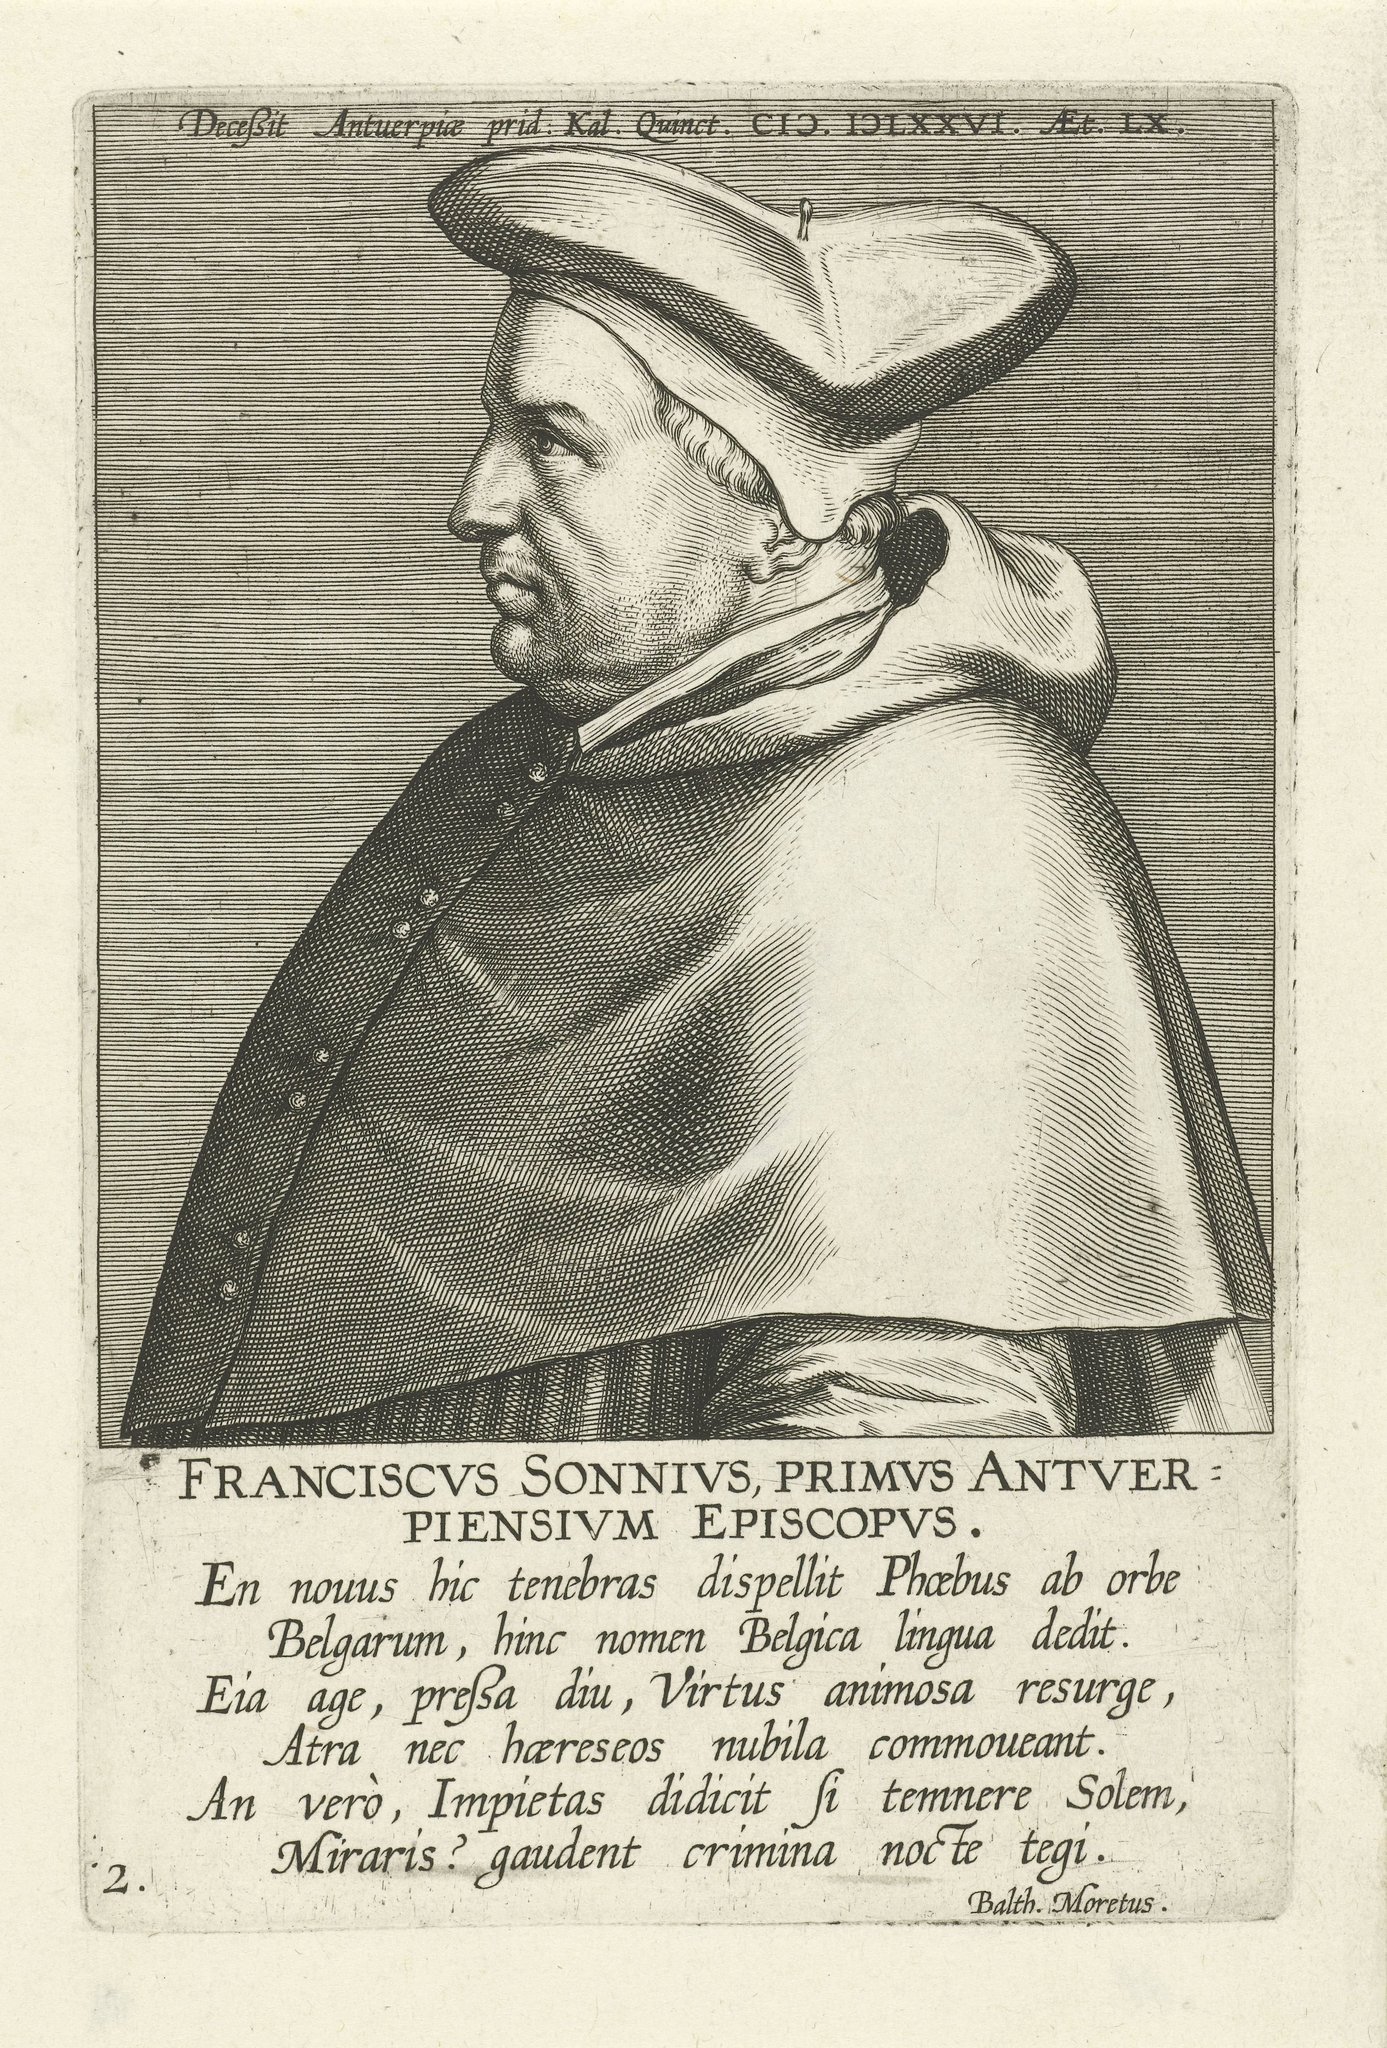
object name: print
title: Franciscvs Sonnivs, Prmvs Antverpiensivm Episcopvs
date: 1604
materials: paper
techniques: engraving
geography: antwerp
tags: antwerp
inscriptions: collector's mark: Lugt 2228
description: Portret van Fransiscus Sonnius, eerste bisschop van Antwerpen. In proefiel naar links. De prent heeft een Latijns boven- en onderschrift en maakt deel uit van een serie van beroemde Nederlandse en Vlaamse geleerden.